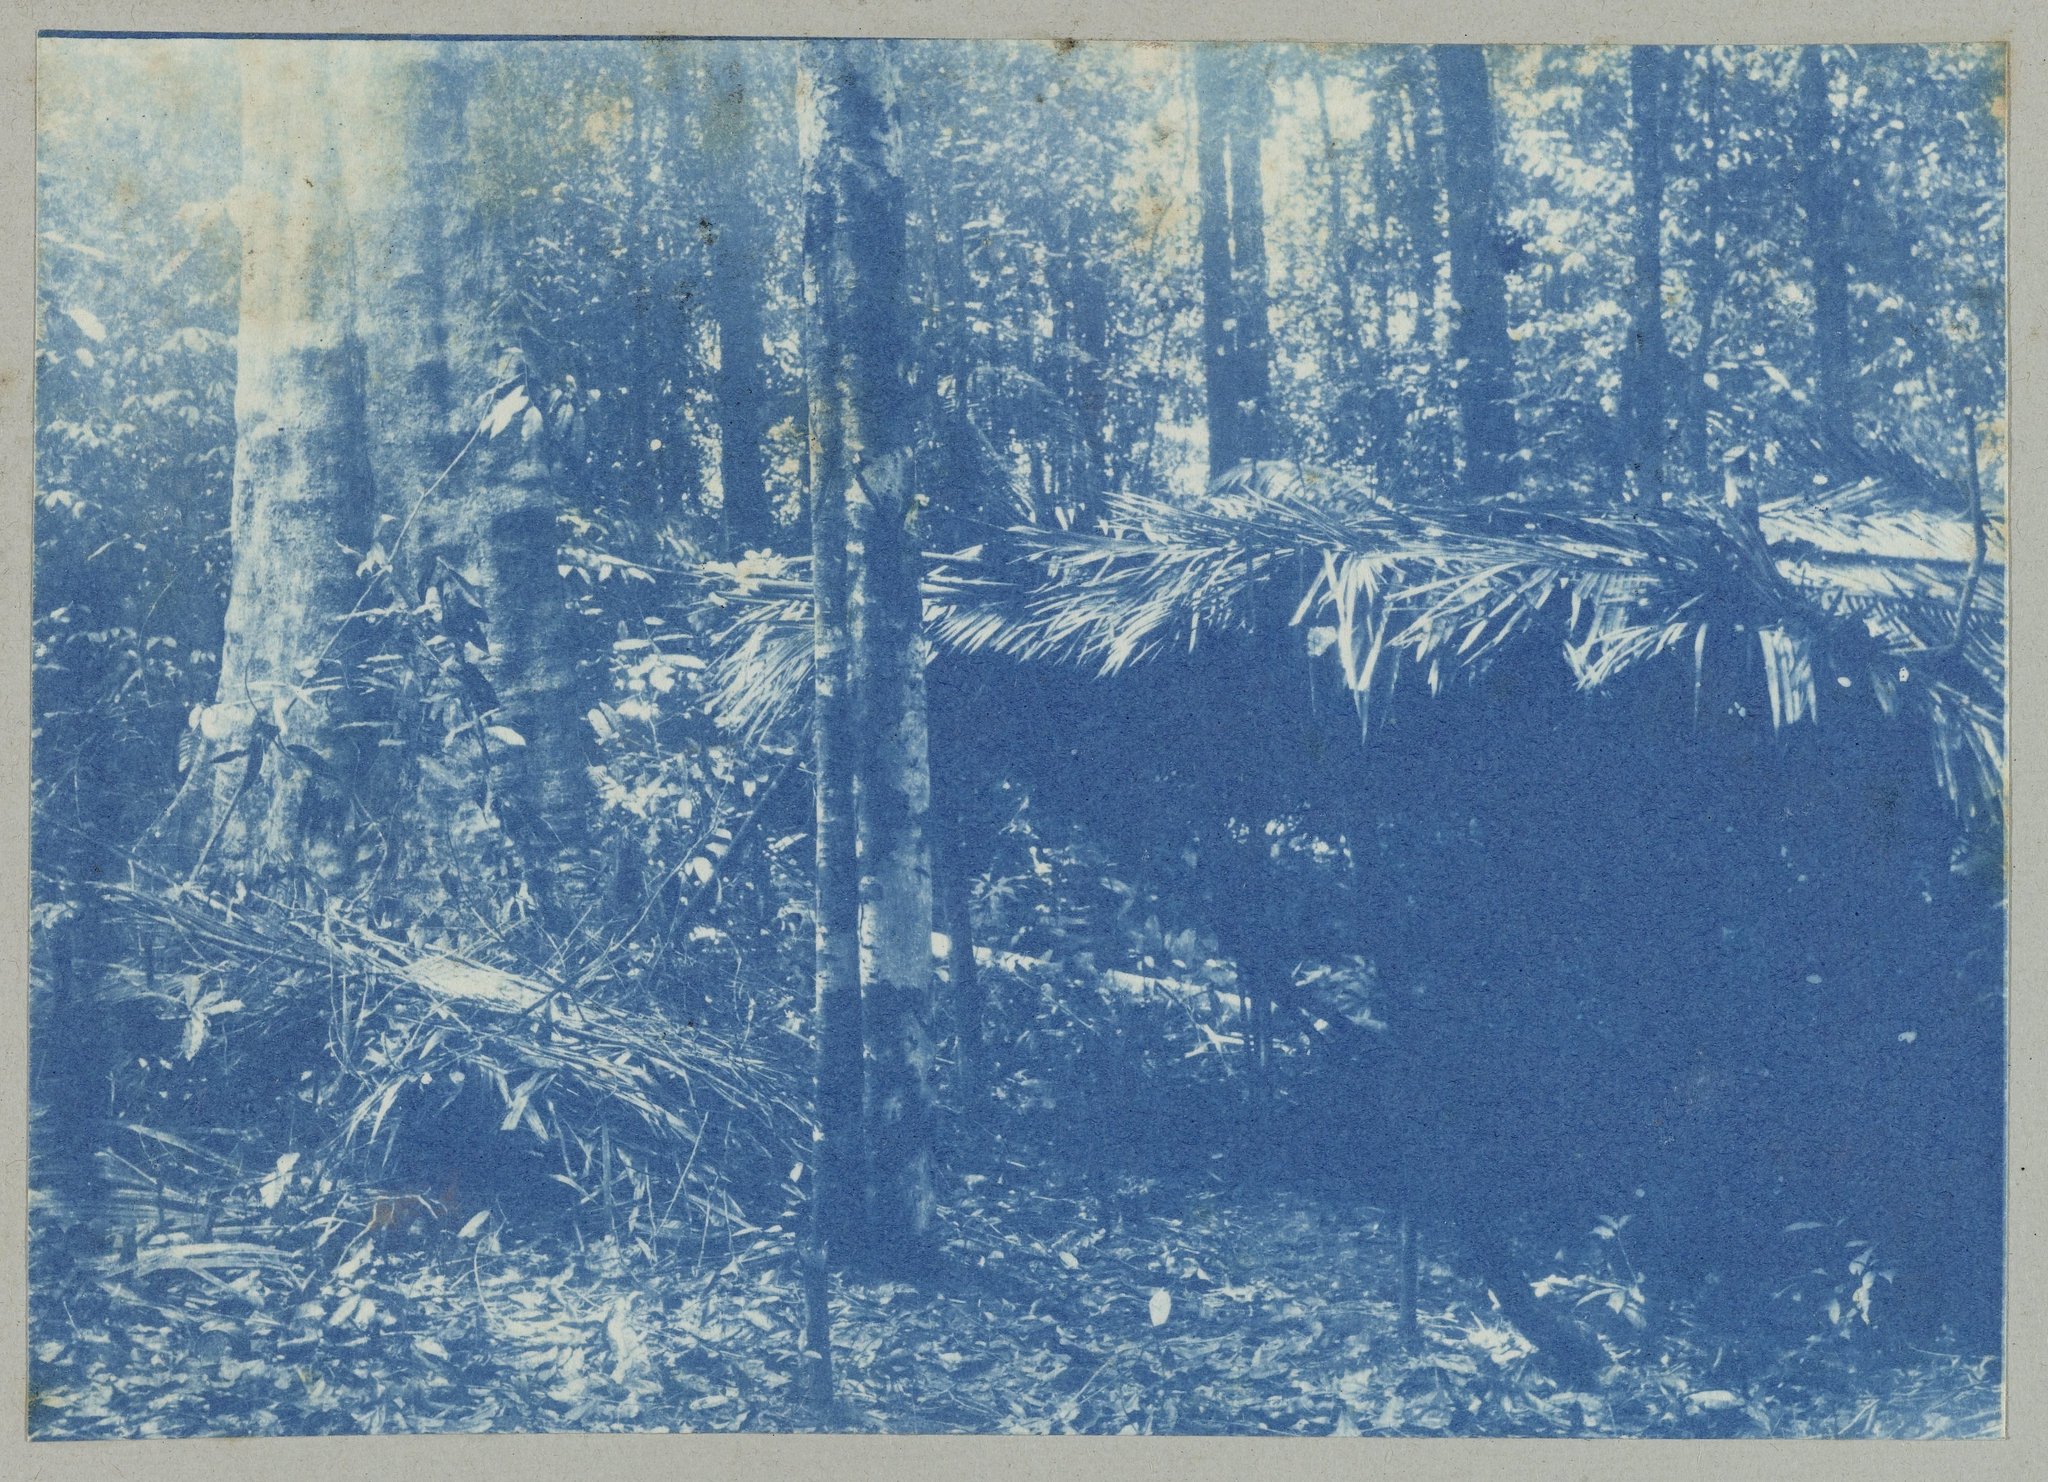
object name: photograph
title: Meetkamp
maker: hendrik doijer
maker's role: engineer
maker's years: 1863-1925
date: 1903-1910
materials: photographic support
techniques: cyanotype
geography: suriname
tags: suriname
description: Gezicht op de hut gebouwd van takken en bladeren in het meetkamp in het oerwoud. Onderdeel van het fotoalbum Souvenir de Voyage (deel 1), over het leven van de familie Doijer in en rond de plantage Ma Retraite in Suriname in de jaren 1903-1910.